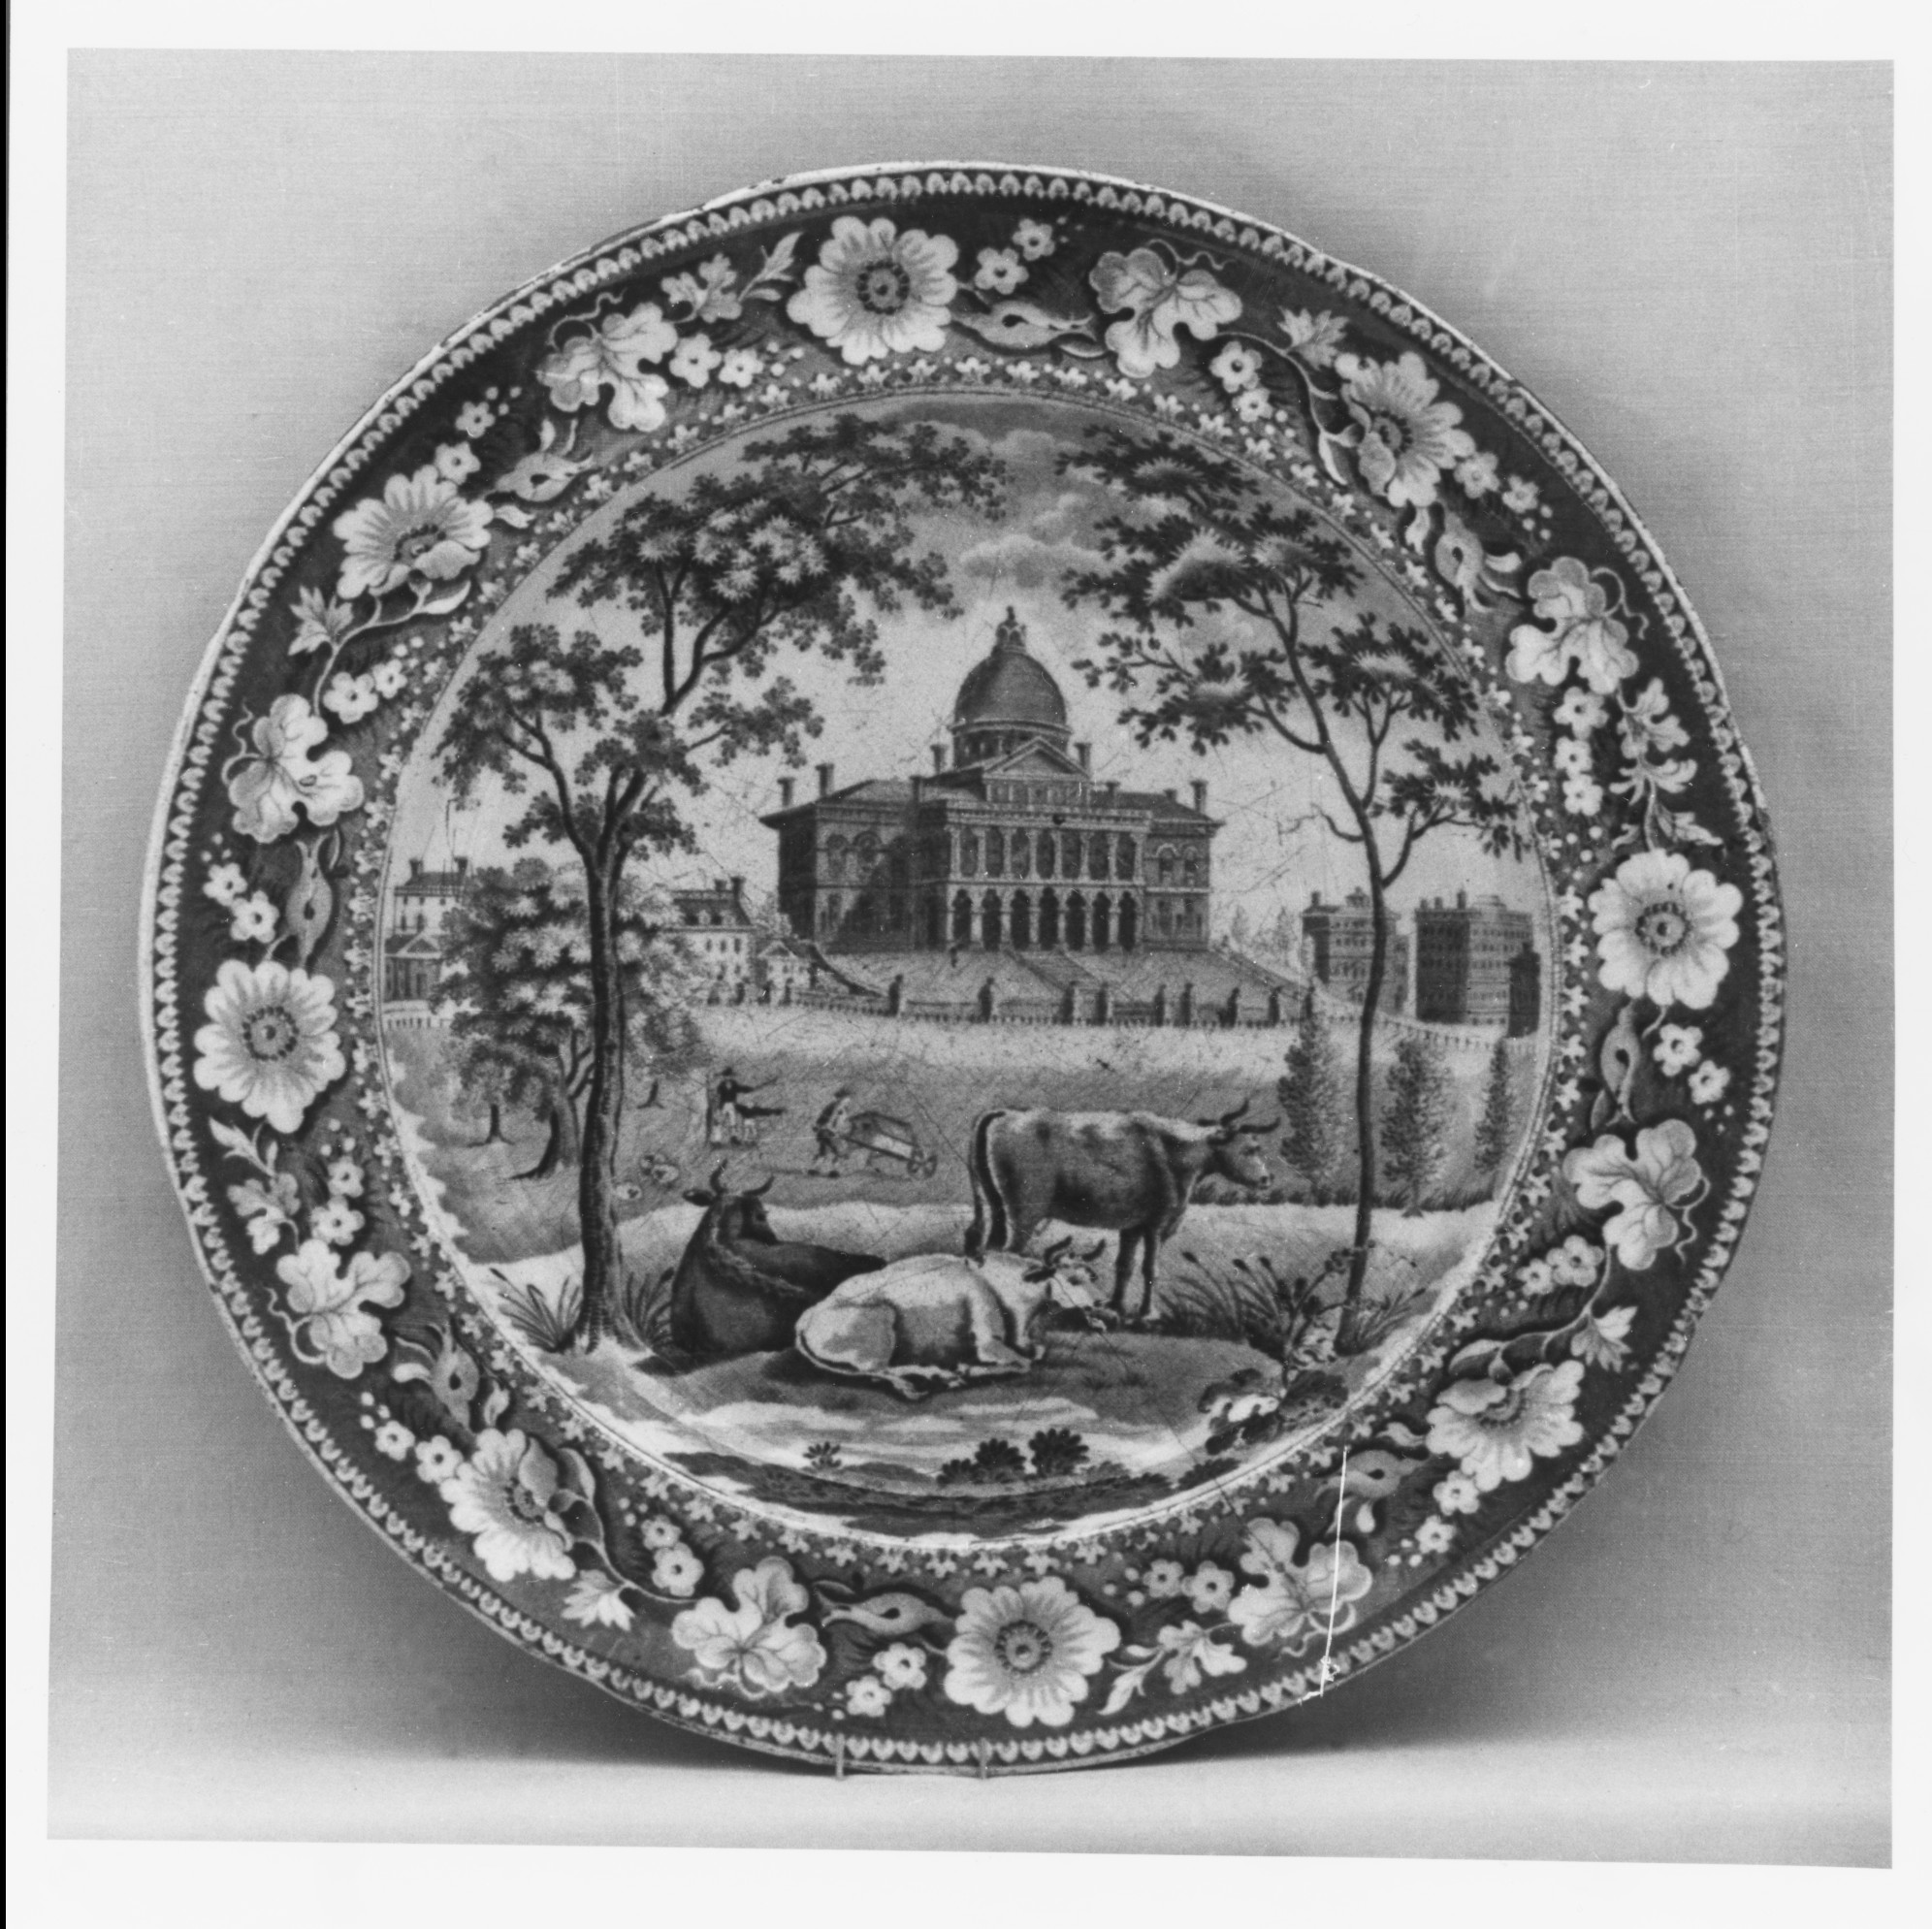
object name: plate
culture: british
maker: john rogers & son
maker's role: maker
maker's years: 1812-1842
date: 1815-1842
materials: earthenware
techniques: transfer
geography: england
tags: buildings,cows